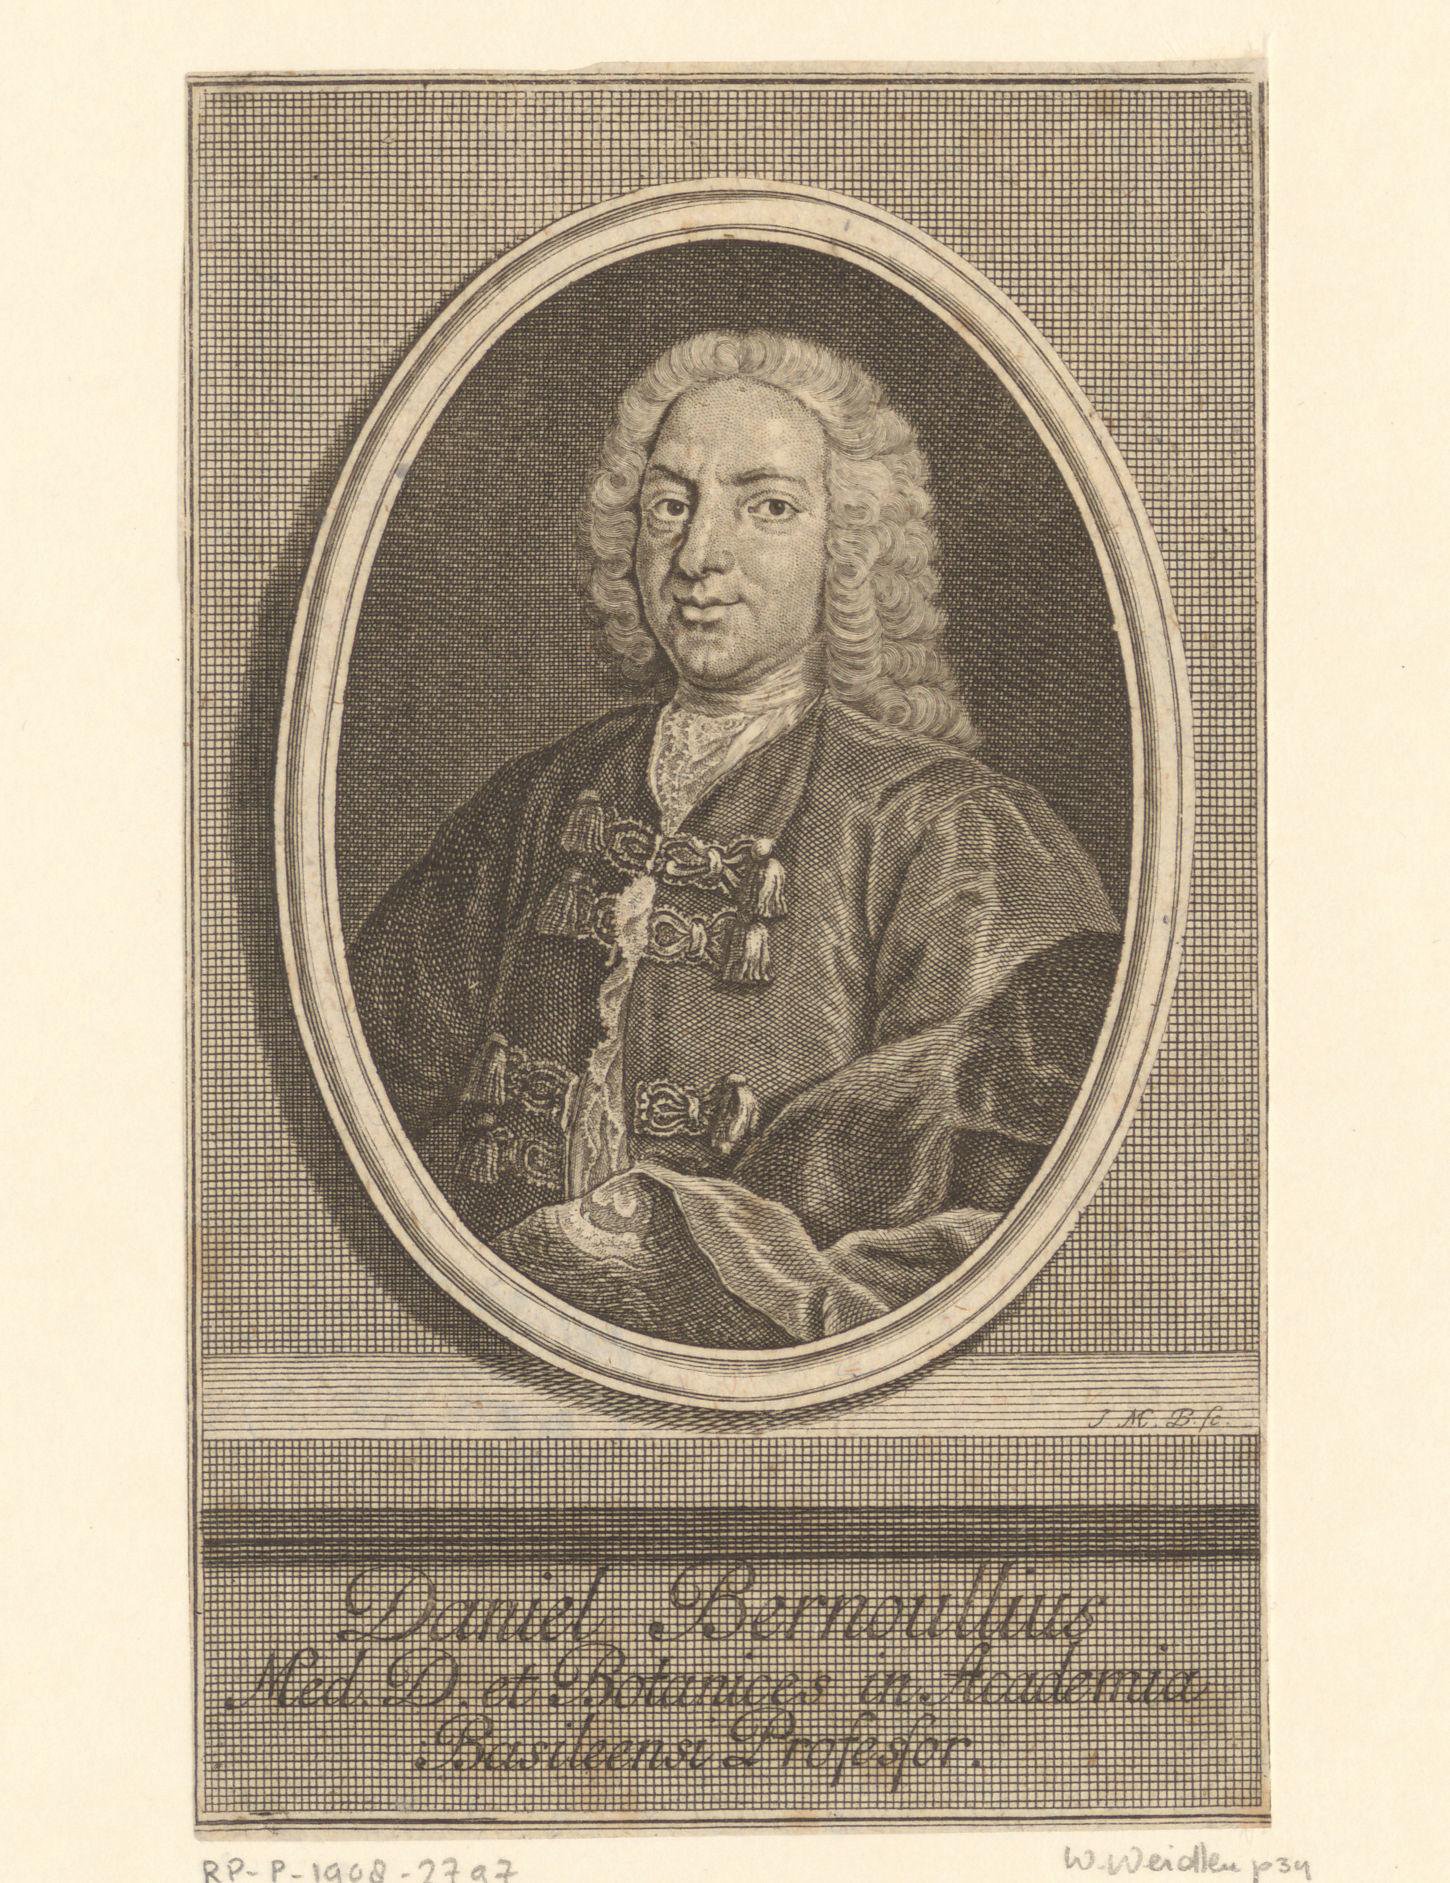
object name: print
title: Portret van Daniel Bernoulli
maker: johann martin bernigeroth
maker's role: print maker, publisher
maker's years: 1713-1767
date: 1745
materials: paper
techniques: engraving, etching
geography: leipzig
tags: historical persons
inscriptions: collector's mark: Lugt 2228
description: Prent ook gebruikt in: Zuverlässige Nachrichten von dem gegenwärtigen Zustande, Veränderung und Wachsthum der Wissenschaften. dl. 65. Leipzig: Johann Friedrich Gleditsch, 1745.